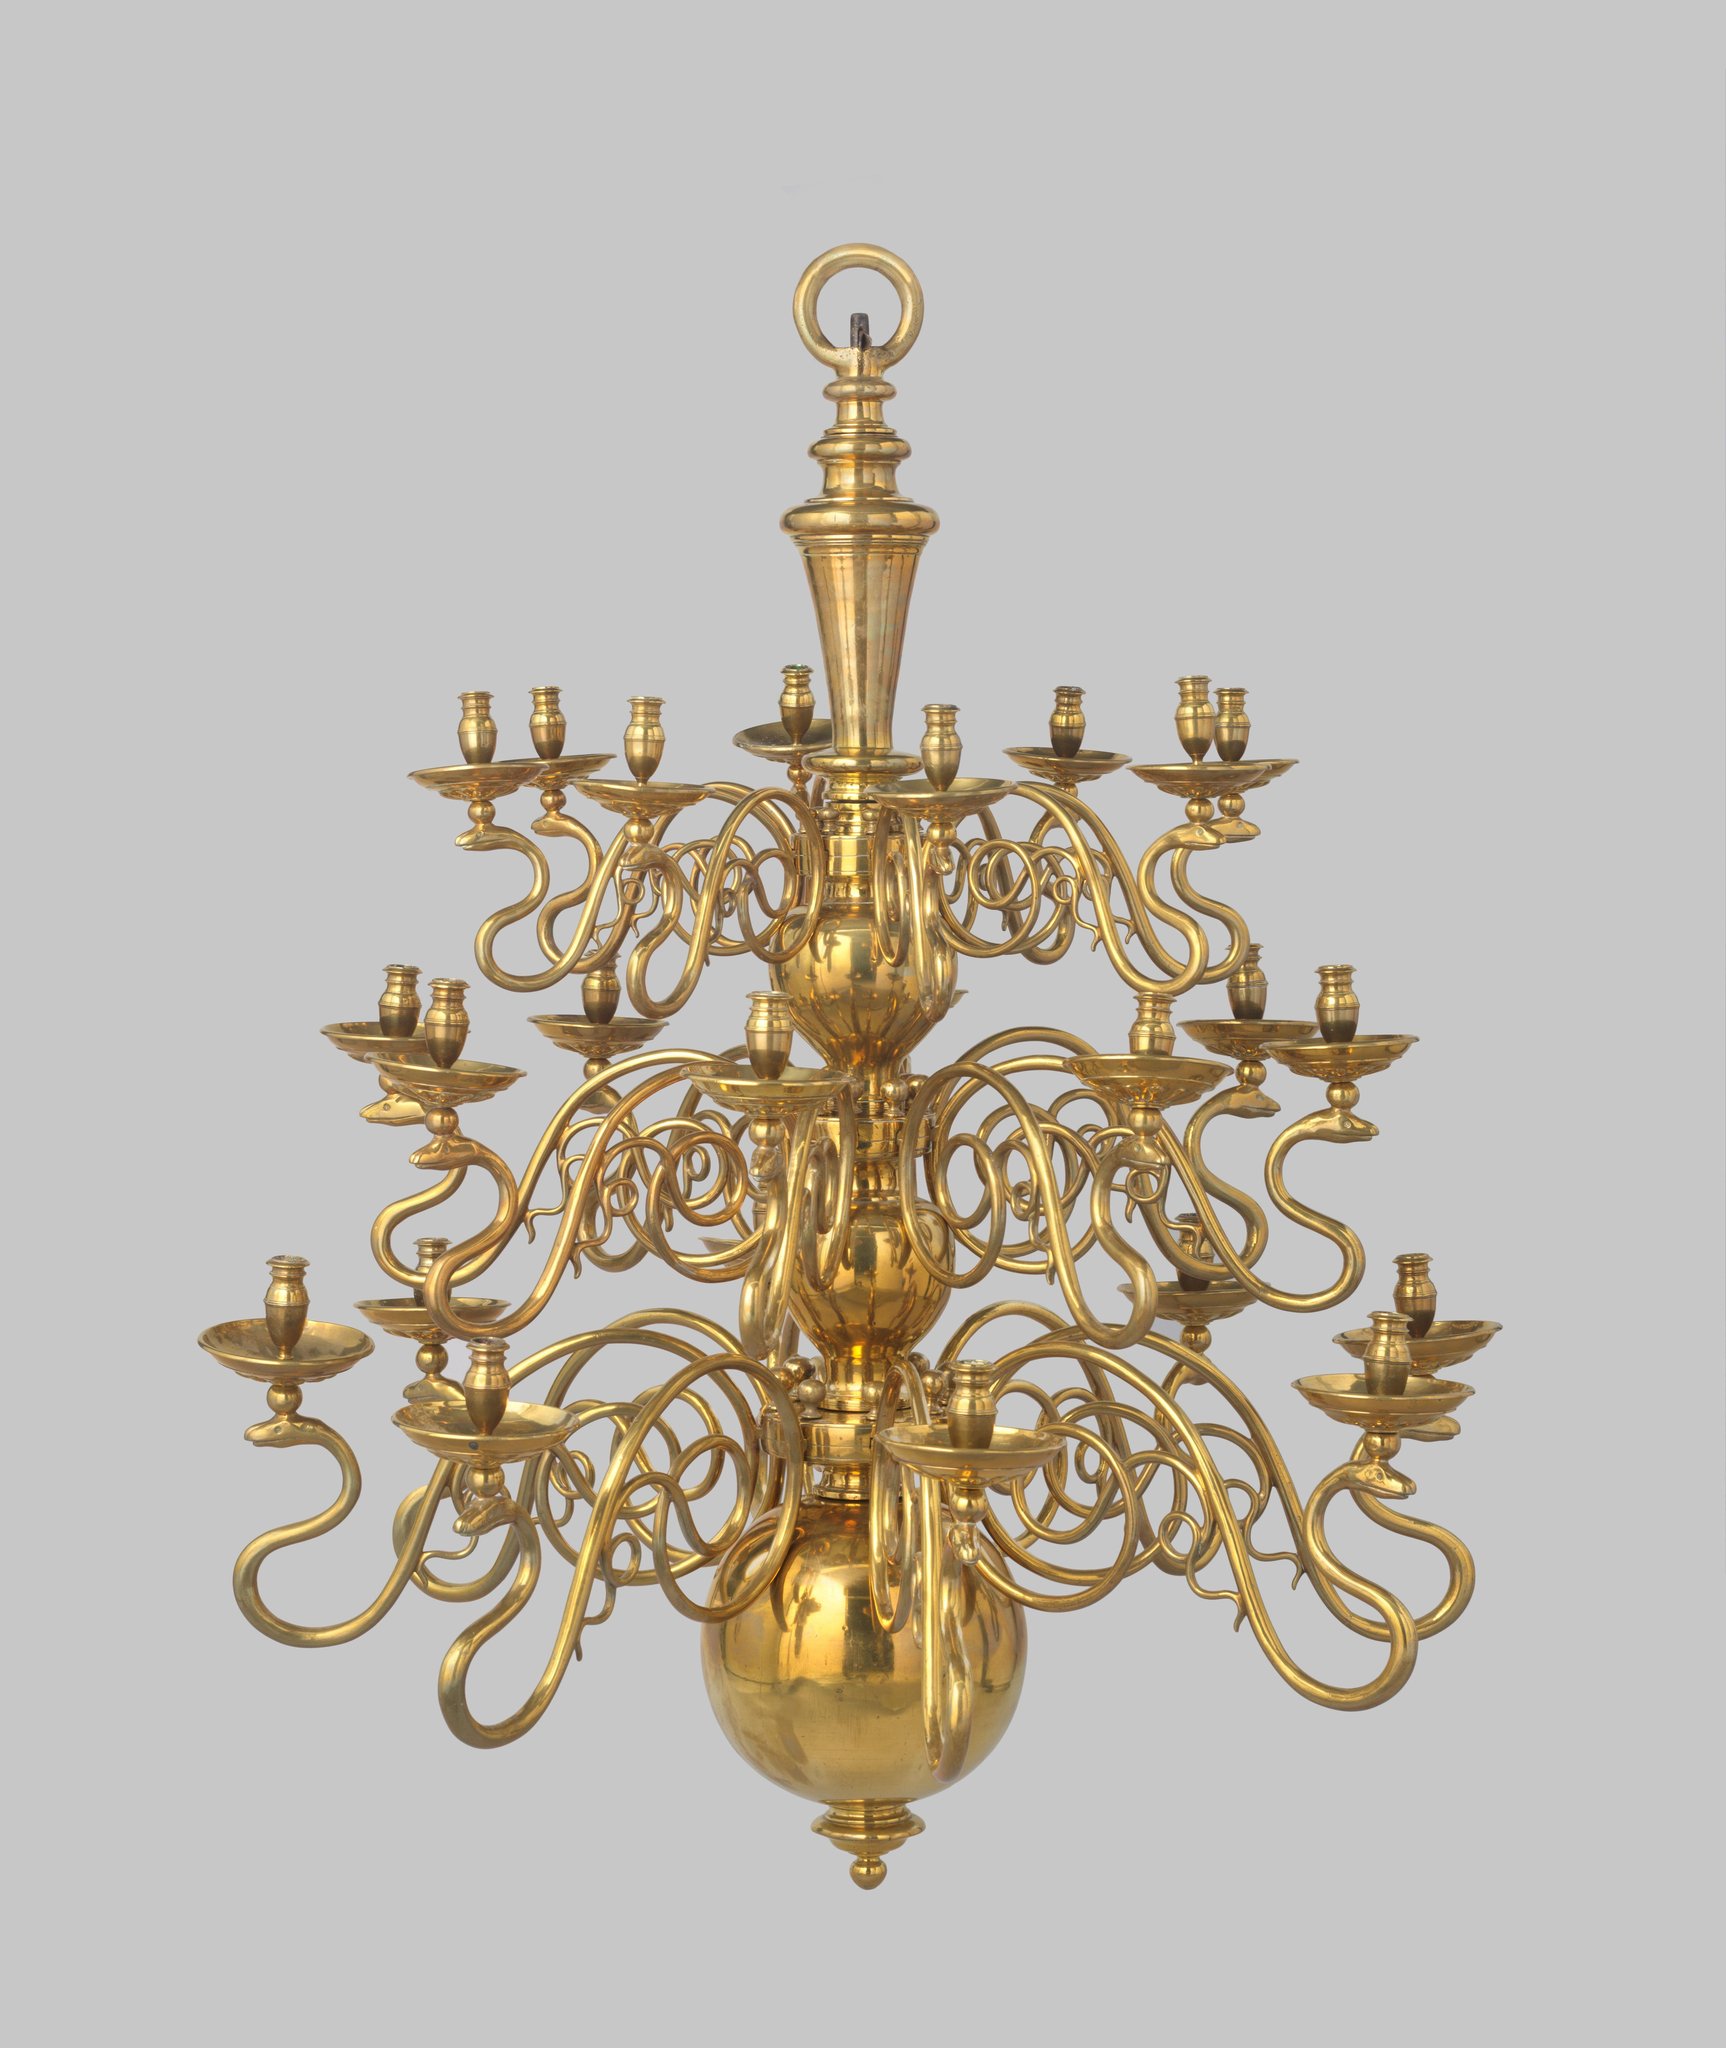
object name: chandelier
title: Stam van een kaarsenkroon in drie hoogten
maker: Anonymous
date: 1625-1650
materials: brass, iron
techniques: casting, turning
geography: northern netherlands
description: Het voorwerp bestaat uit een ronde smeedijzeren stang, een ijzeren splitpen en de volgende gegoten en daarna op de draaibank bewerkte delen: de hangring, het bovenste stamdeel met de middelste standring, de onderste standring, de bol en de knop. De ronde hangringgaat onderaan over in een met een zware nodus versierde holle cylinder. Het bovenste stamdeel is omgekeerd kegelvormig en met een zware geprofileerde rib versierd. De daaronder geplaatste ring is holrond geprofileerd. Het volgende onderdeel bestaat uit de bovenste standring met een bijna bolvormige baluster, waarvan de voetrand met drie gegroefde ringen is versierd. Deze bovenste standring is bij de arms- en de pingaten I t/m VIII genummerd. Het onderdeel met de middelste standring heeft een overeenkomstige balustervorm alsmede eenzelfde op de kop aangegeven nummering bij de armsgaten. De onderste standring heeft bij de armsgaten een op de kop aangegeven nummering. De bol is aan boven- en onderkant voorzien van een gat. De krachtig geprofileerde knop, die in een rond knopje eindigt, is aan de smeedijzeren stang bevestigd. Deze heeft bovenaan een spleet voor de splitpen. Bij de stamdelen is de volgorde van montering door middel van inkepinkjes in de gatranden aangegeven.